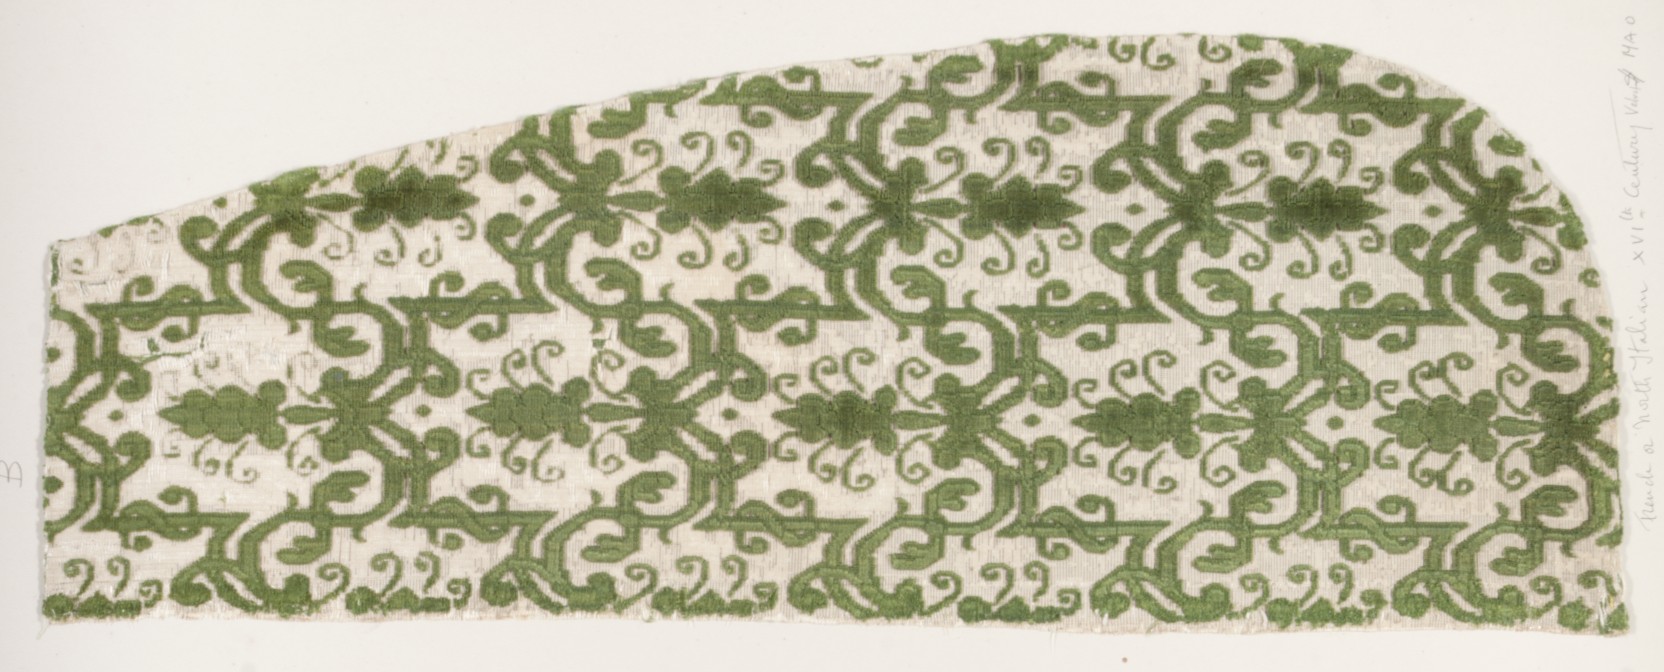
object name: fragment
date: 1501-1600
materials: metal thread, silk